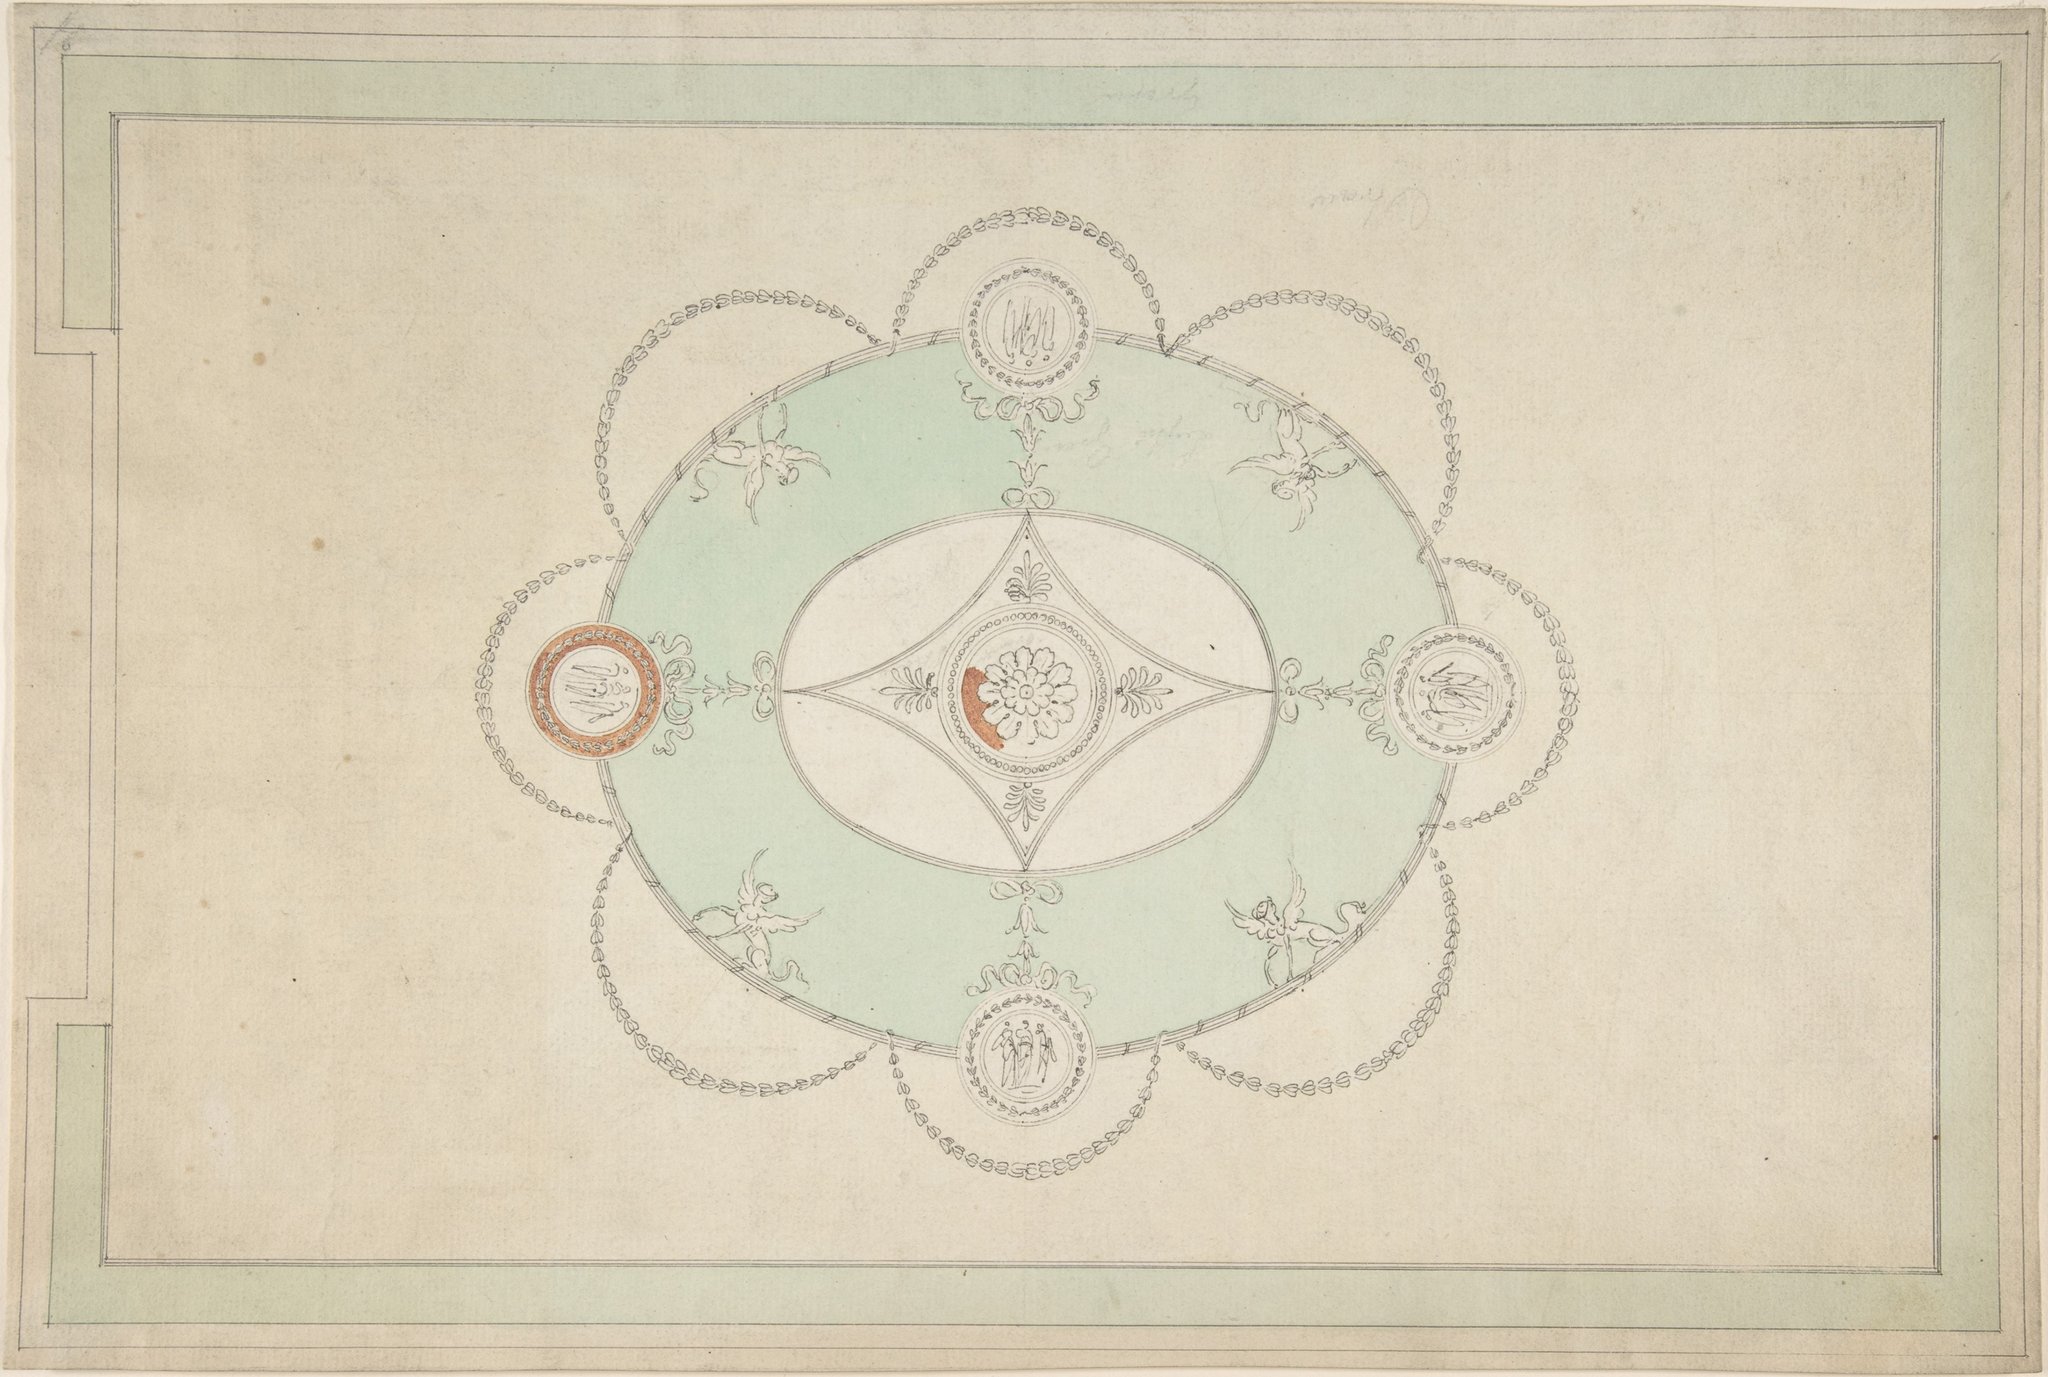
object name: drawing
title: Design for a Ceiling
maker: james wyatt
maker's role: artist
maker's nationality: british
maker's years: 1746-1813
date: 1701-1900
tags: flowers